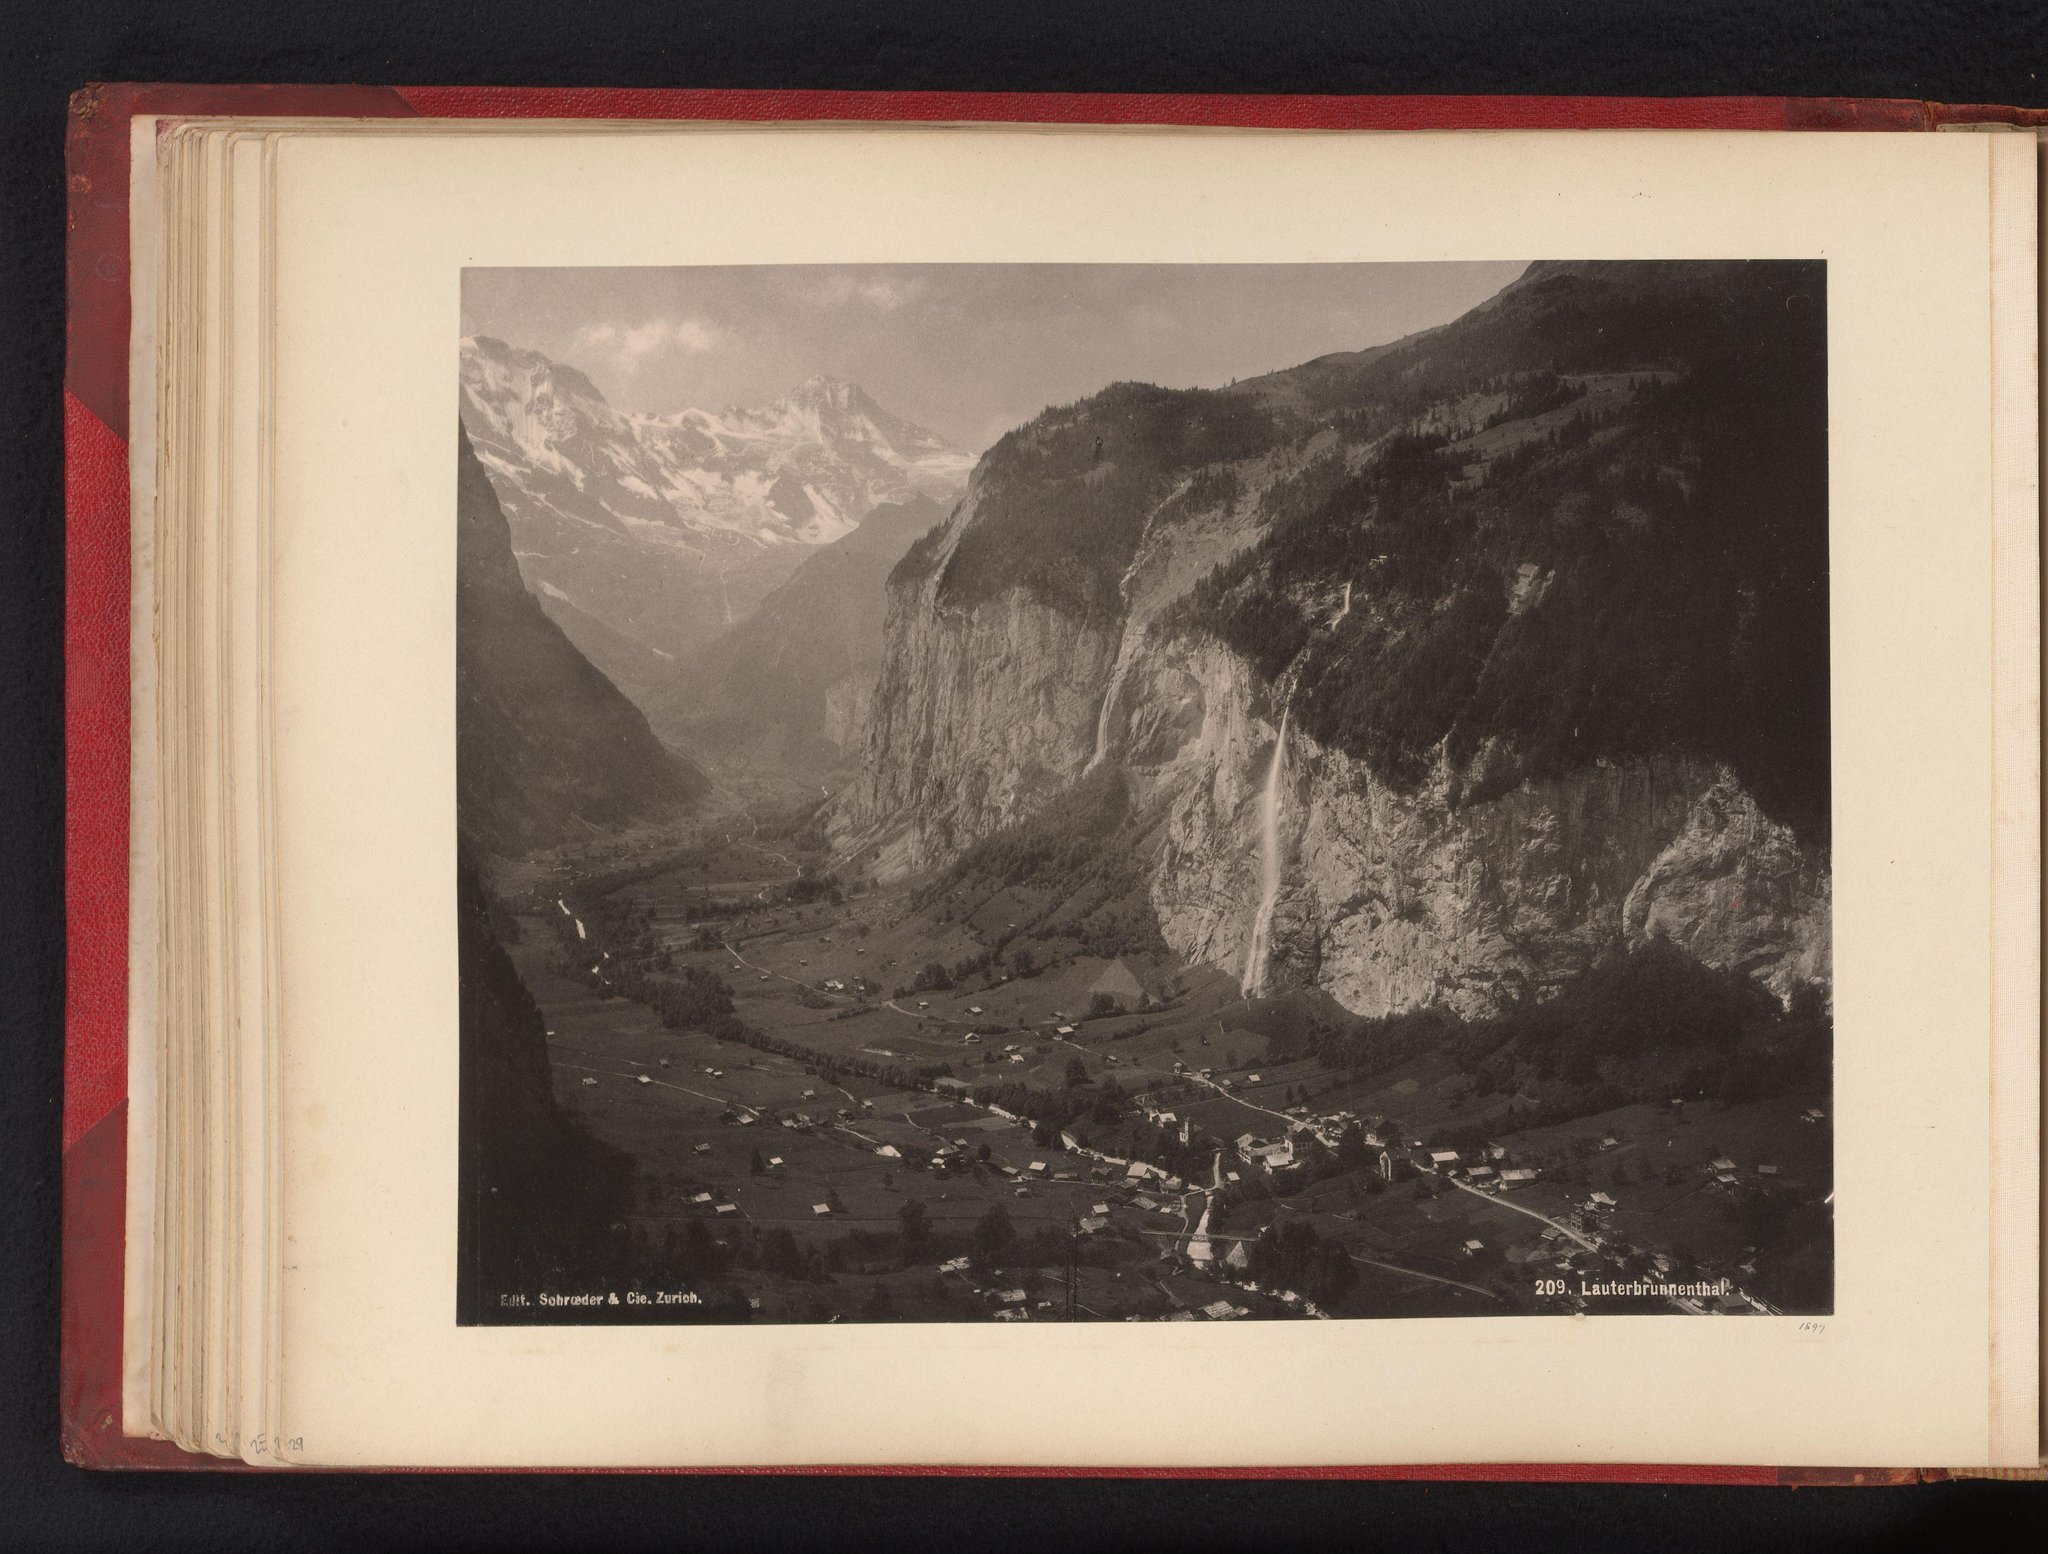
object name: photomechanical print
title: Gezicht op het Lauterbunnental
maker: Anonymous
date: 1897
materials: paper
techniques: photograph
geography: zurich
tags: dale, valley, waterfall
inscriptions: inscription: ‘Edit. Schroeder & Cie. Zürcih./ 209. Lauterbrunnenthal’, annotation: ‘1897’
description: Deze prent maakt deel uit van een album.